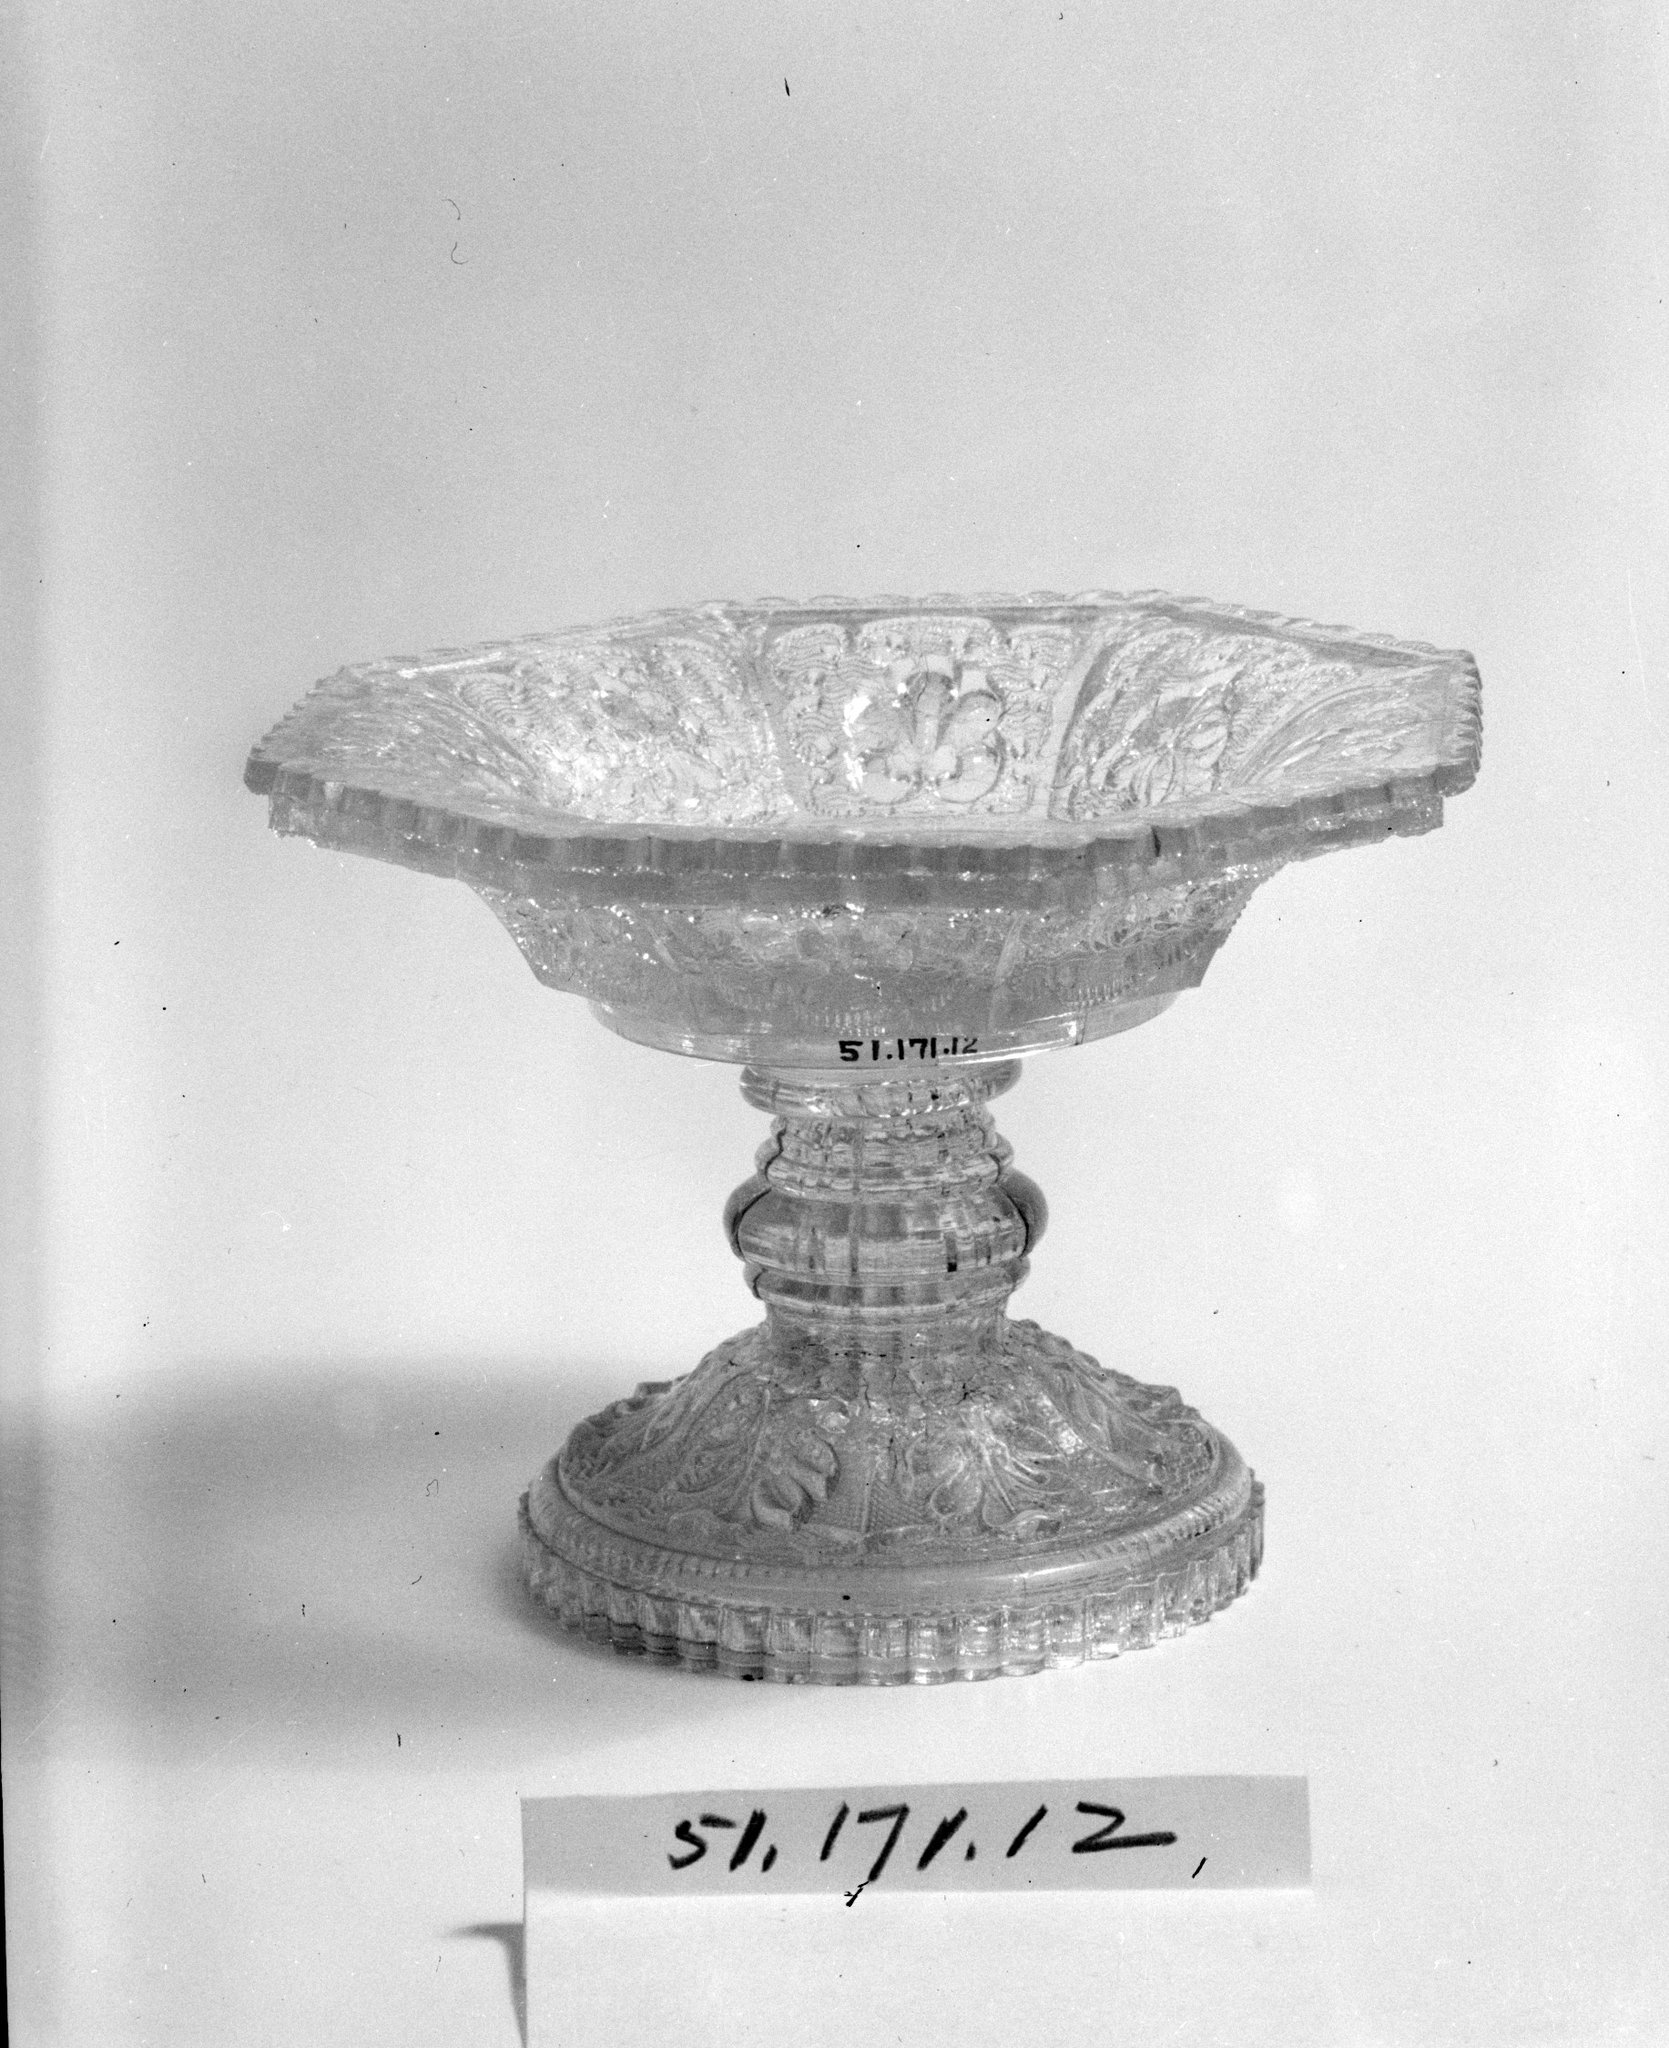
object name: compote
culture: american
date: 1830-1835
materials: glass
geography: united states